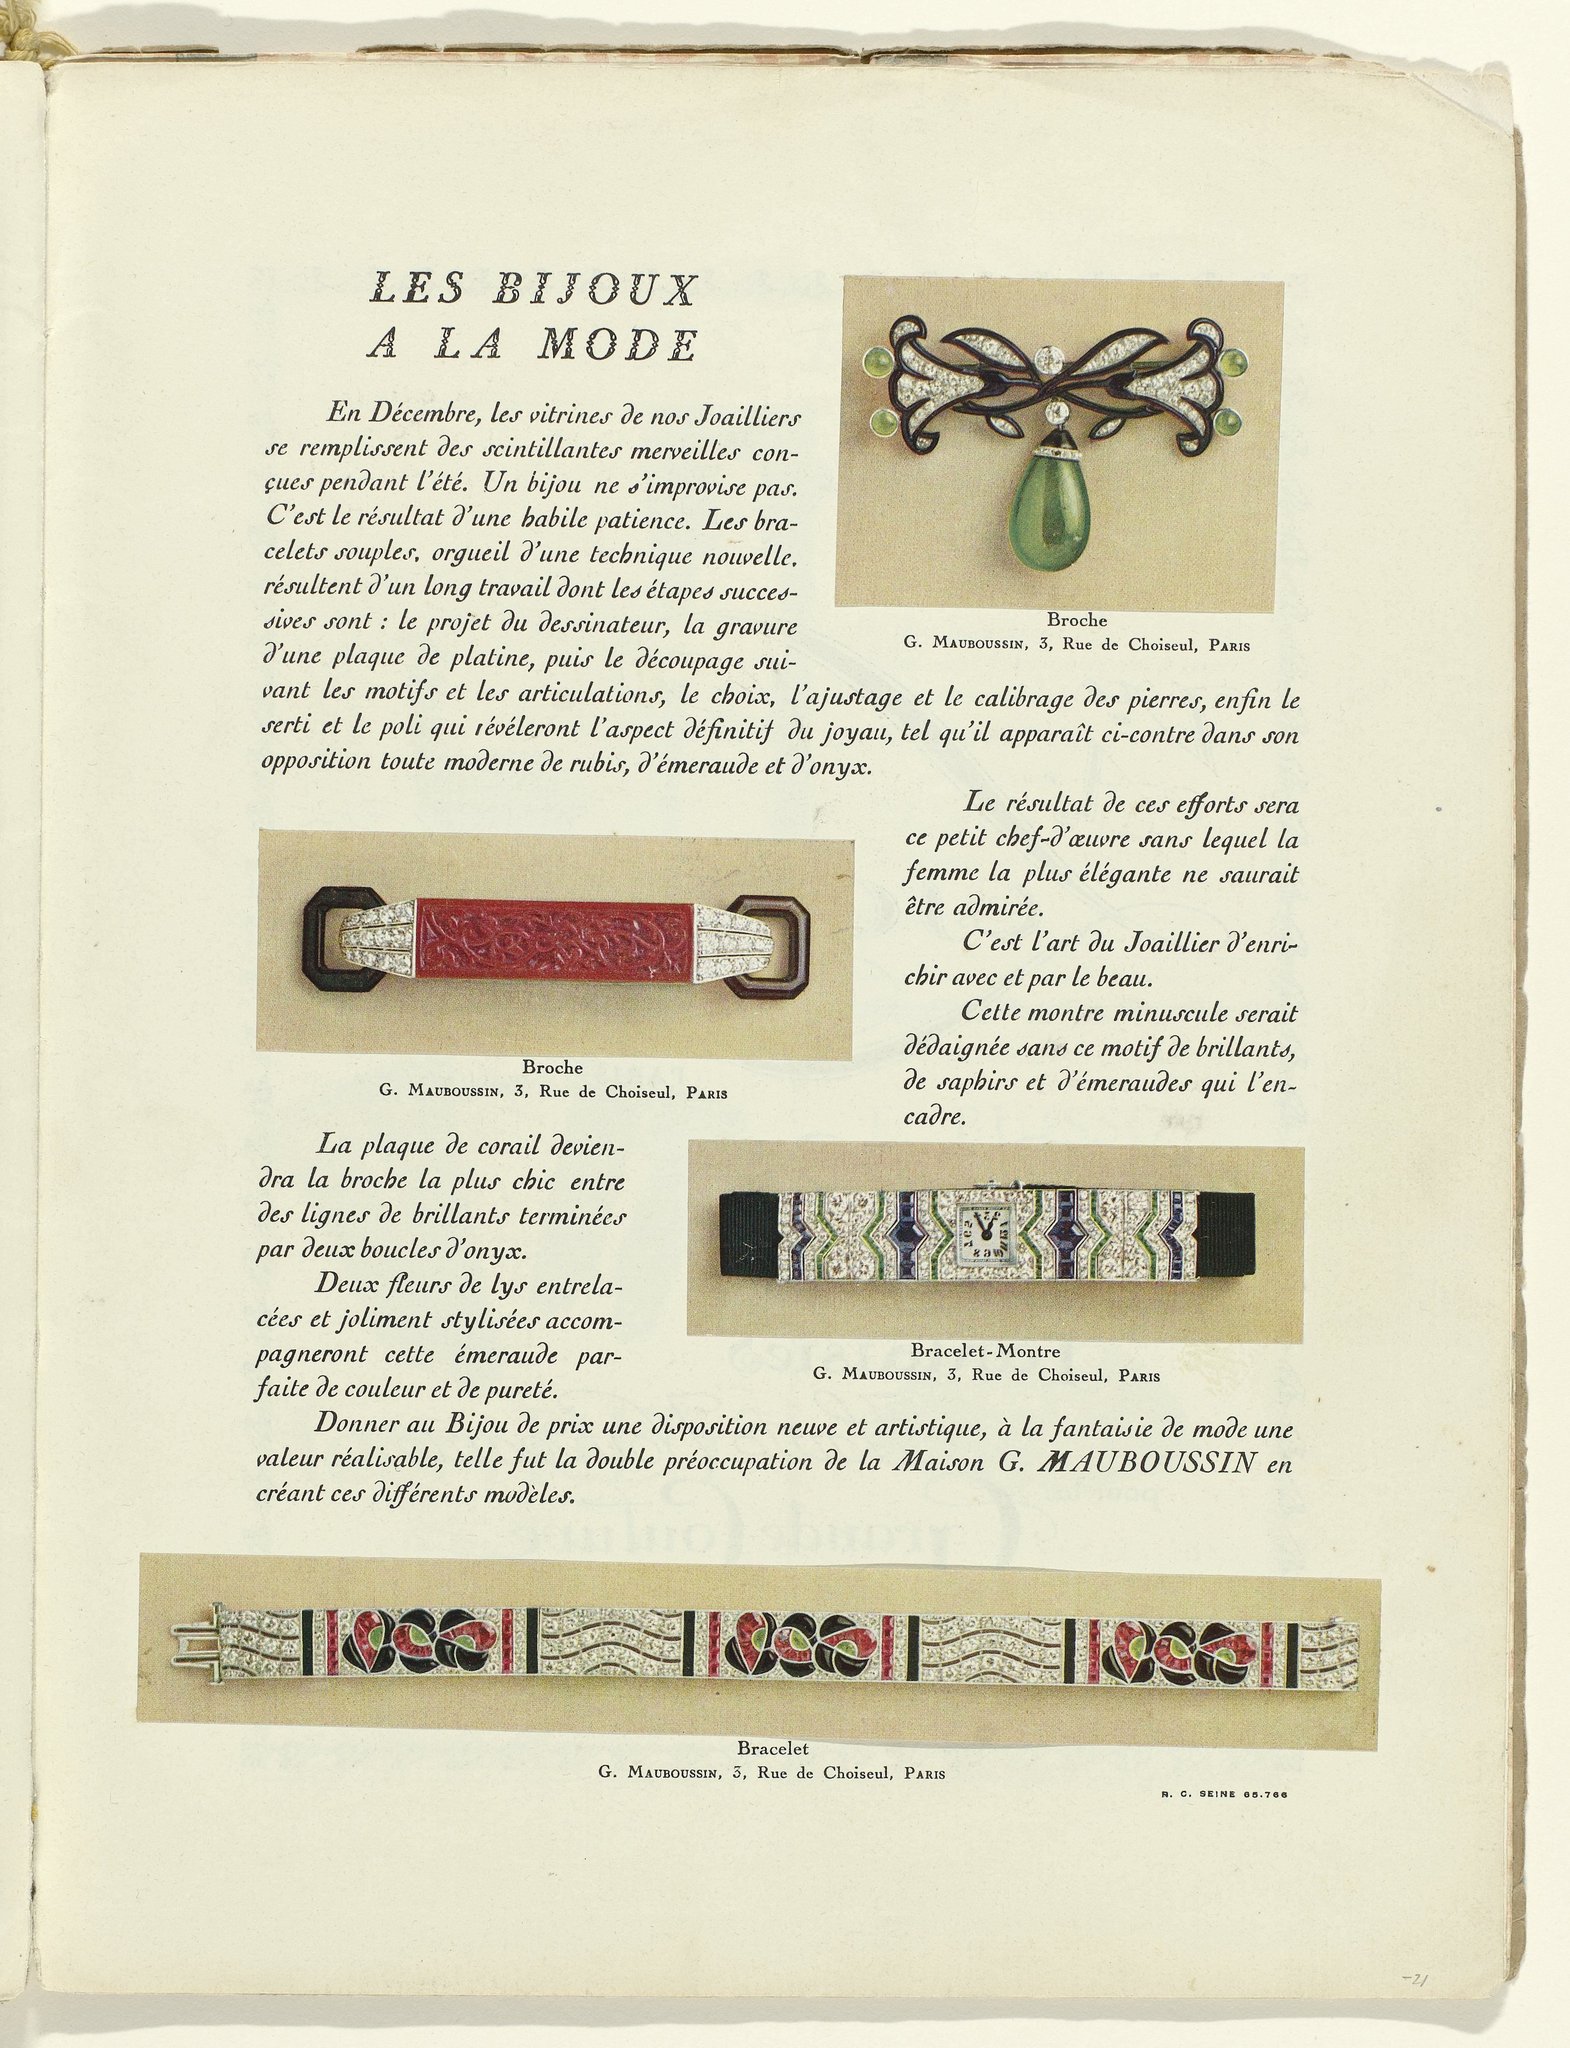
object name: magazine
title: Art - Goût - Beauté, Feuillets de l' élégance féminine, Janvier 1924, No. 41, 4e Année, p. 21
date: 1924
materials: paper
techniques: printing, lithograph, photography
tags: brooch, agraffe, clasp (+ women's clothes), fashion plates, bracelet, wristlet (+ women's clothes)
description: Tekst 'Les bijoux a la mode' met vier illustraties van sieraden van 'G. Mauboussin, 3, Rue de Choiseul, Paris: Broche / Broche / Bracelet-Montre / Bracelet.' Pagina uit het modetijdschrift Art-Goût-Beauté (1920-1933).